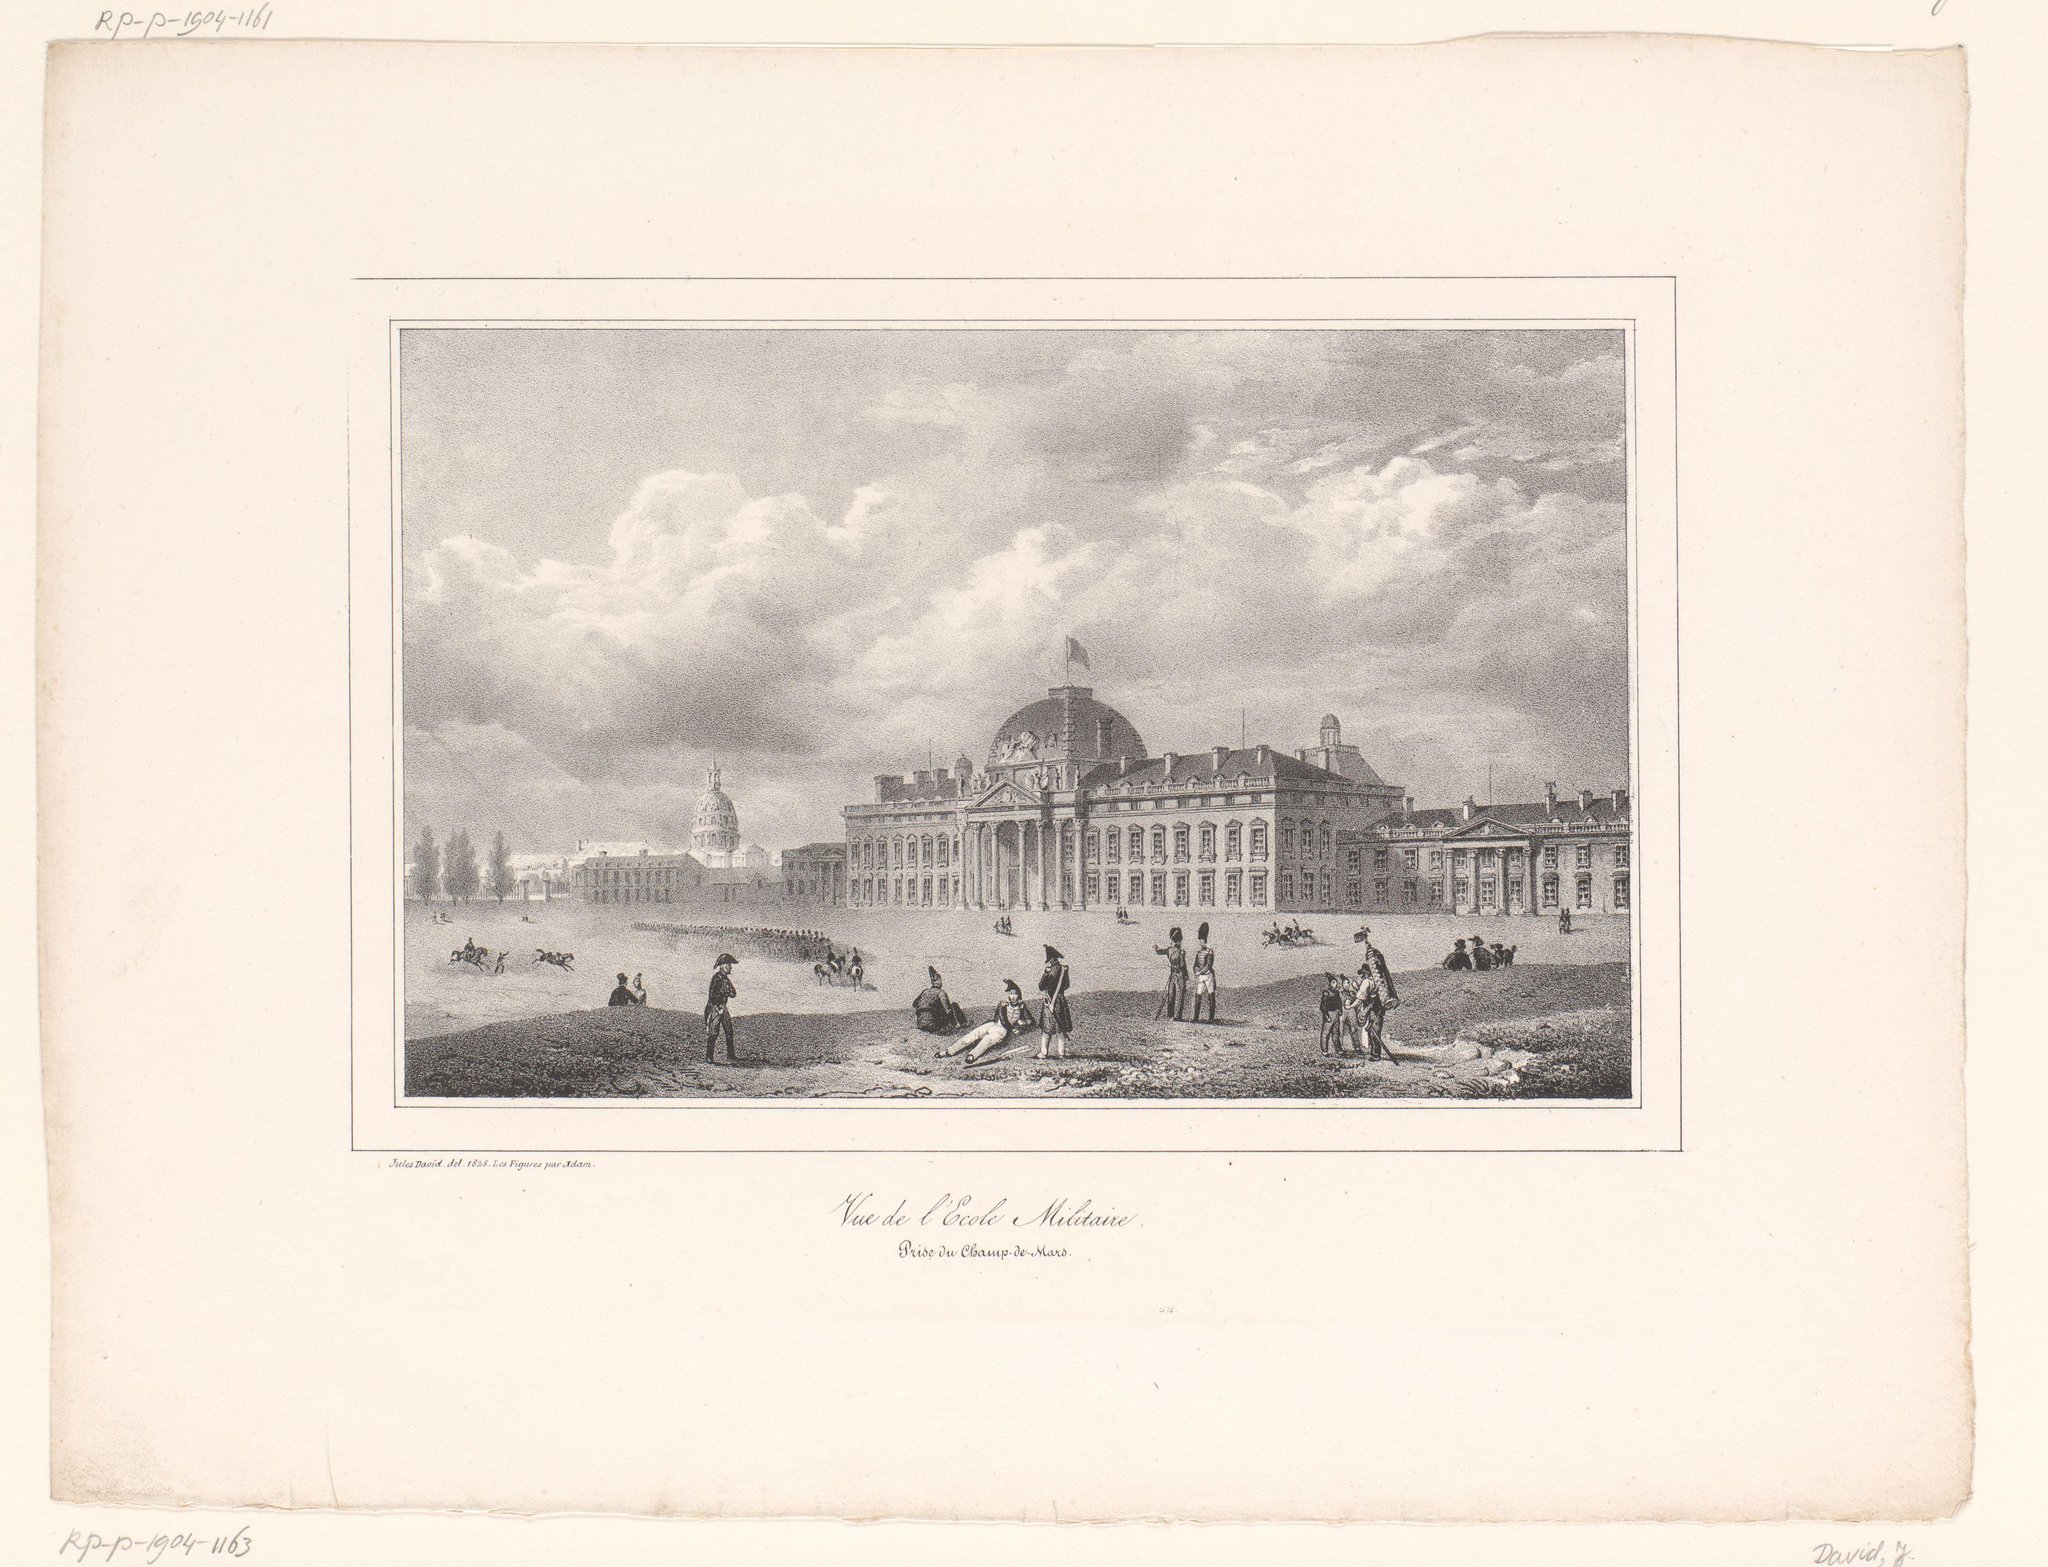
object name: print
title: Vue de l'École Militaire, prise du Champs-de-Mars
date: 1828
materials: paper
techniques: lithograph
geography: paris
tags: military academy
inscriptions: collector's mark: Lugt 2228a